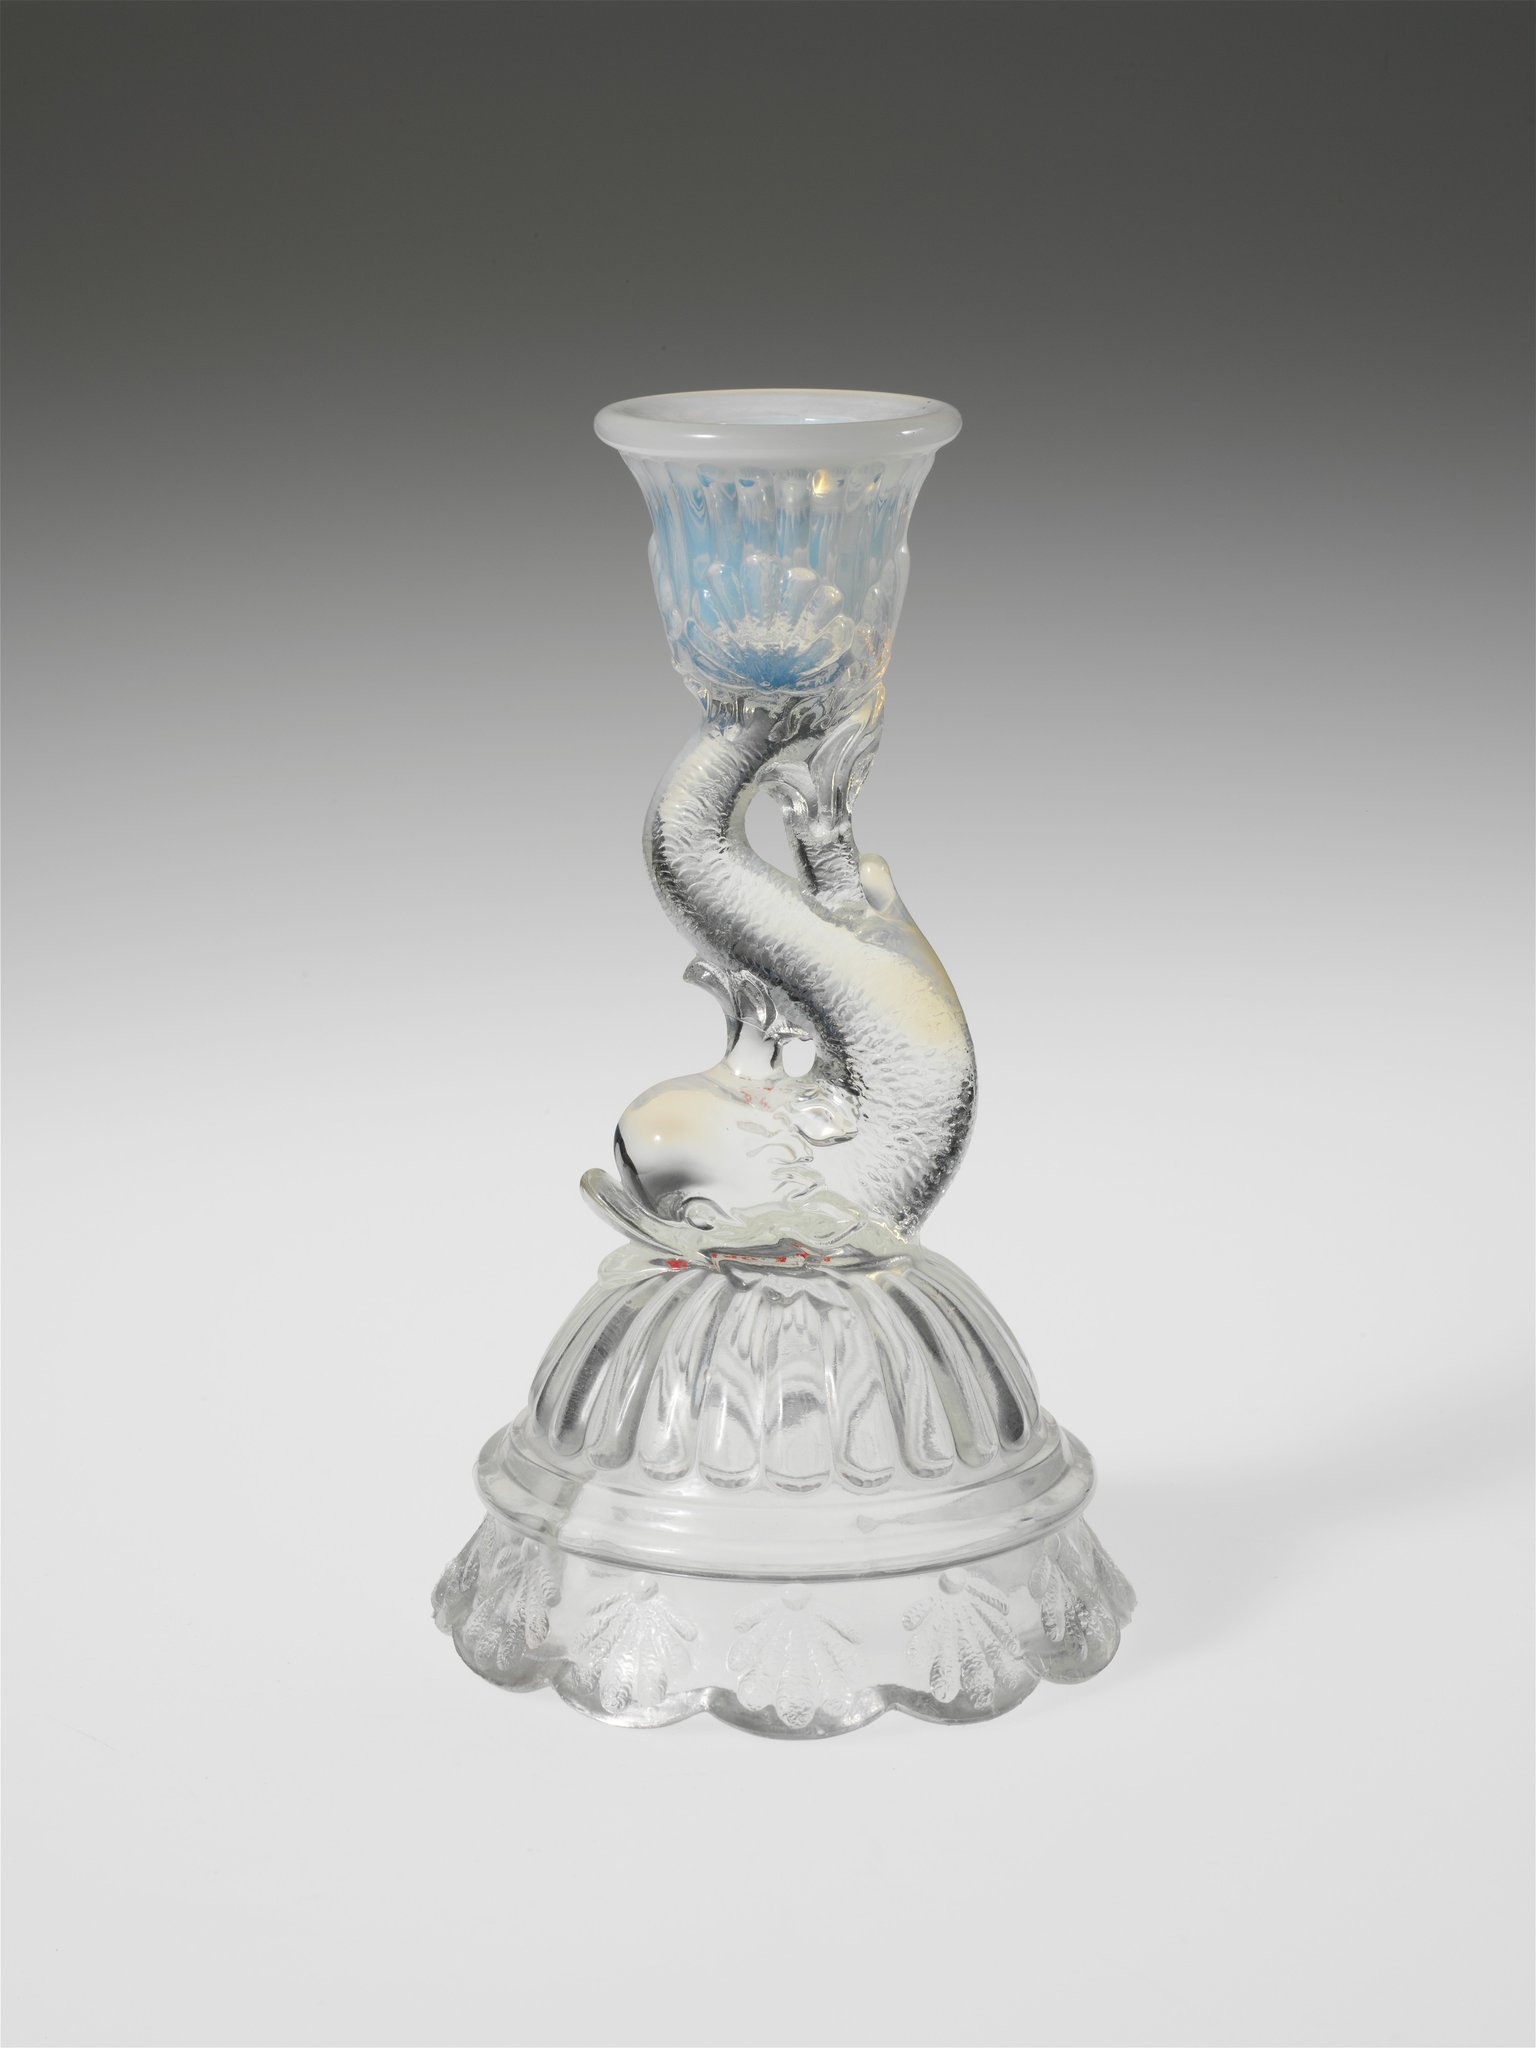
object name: candlestick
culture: american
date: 1875-1900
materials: glass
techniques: pressed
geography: united states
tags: dolphins